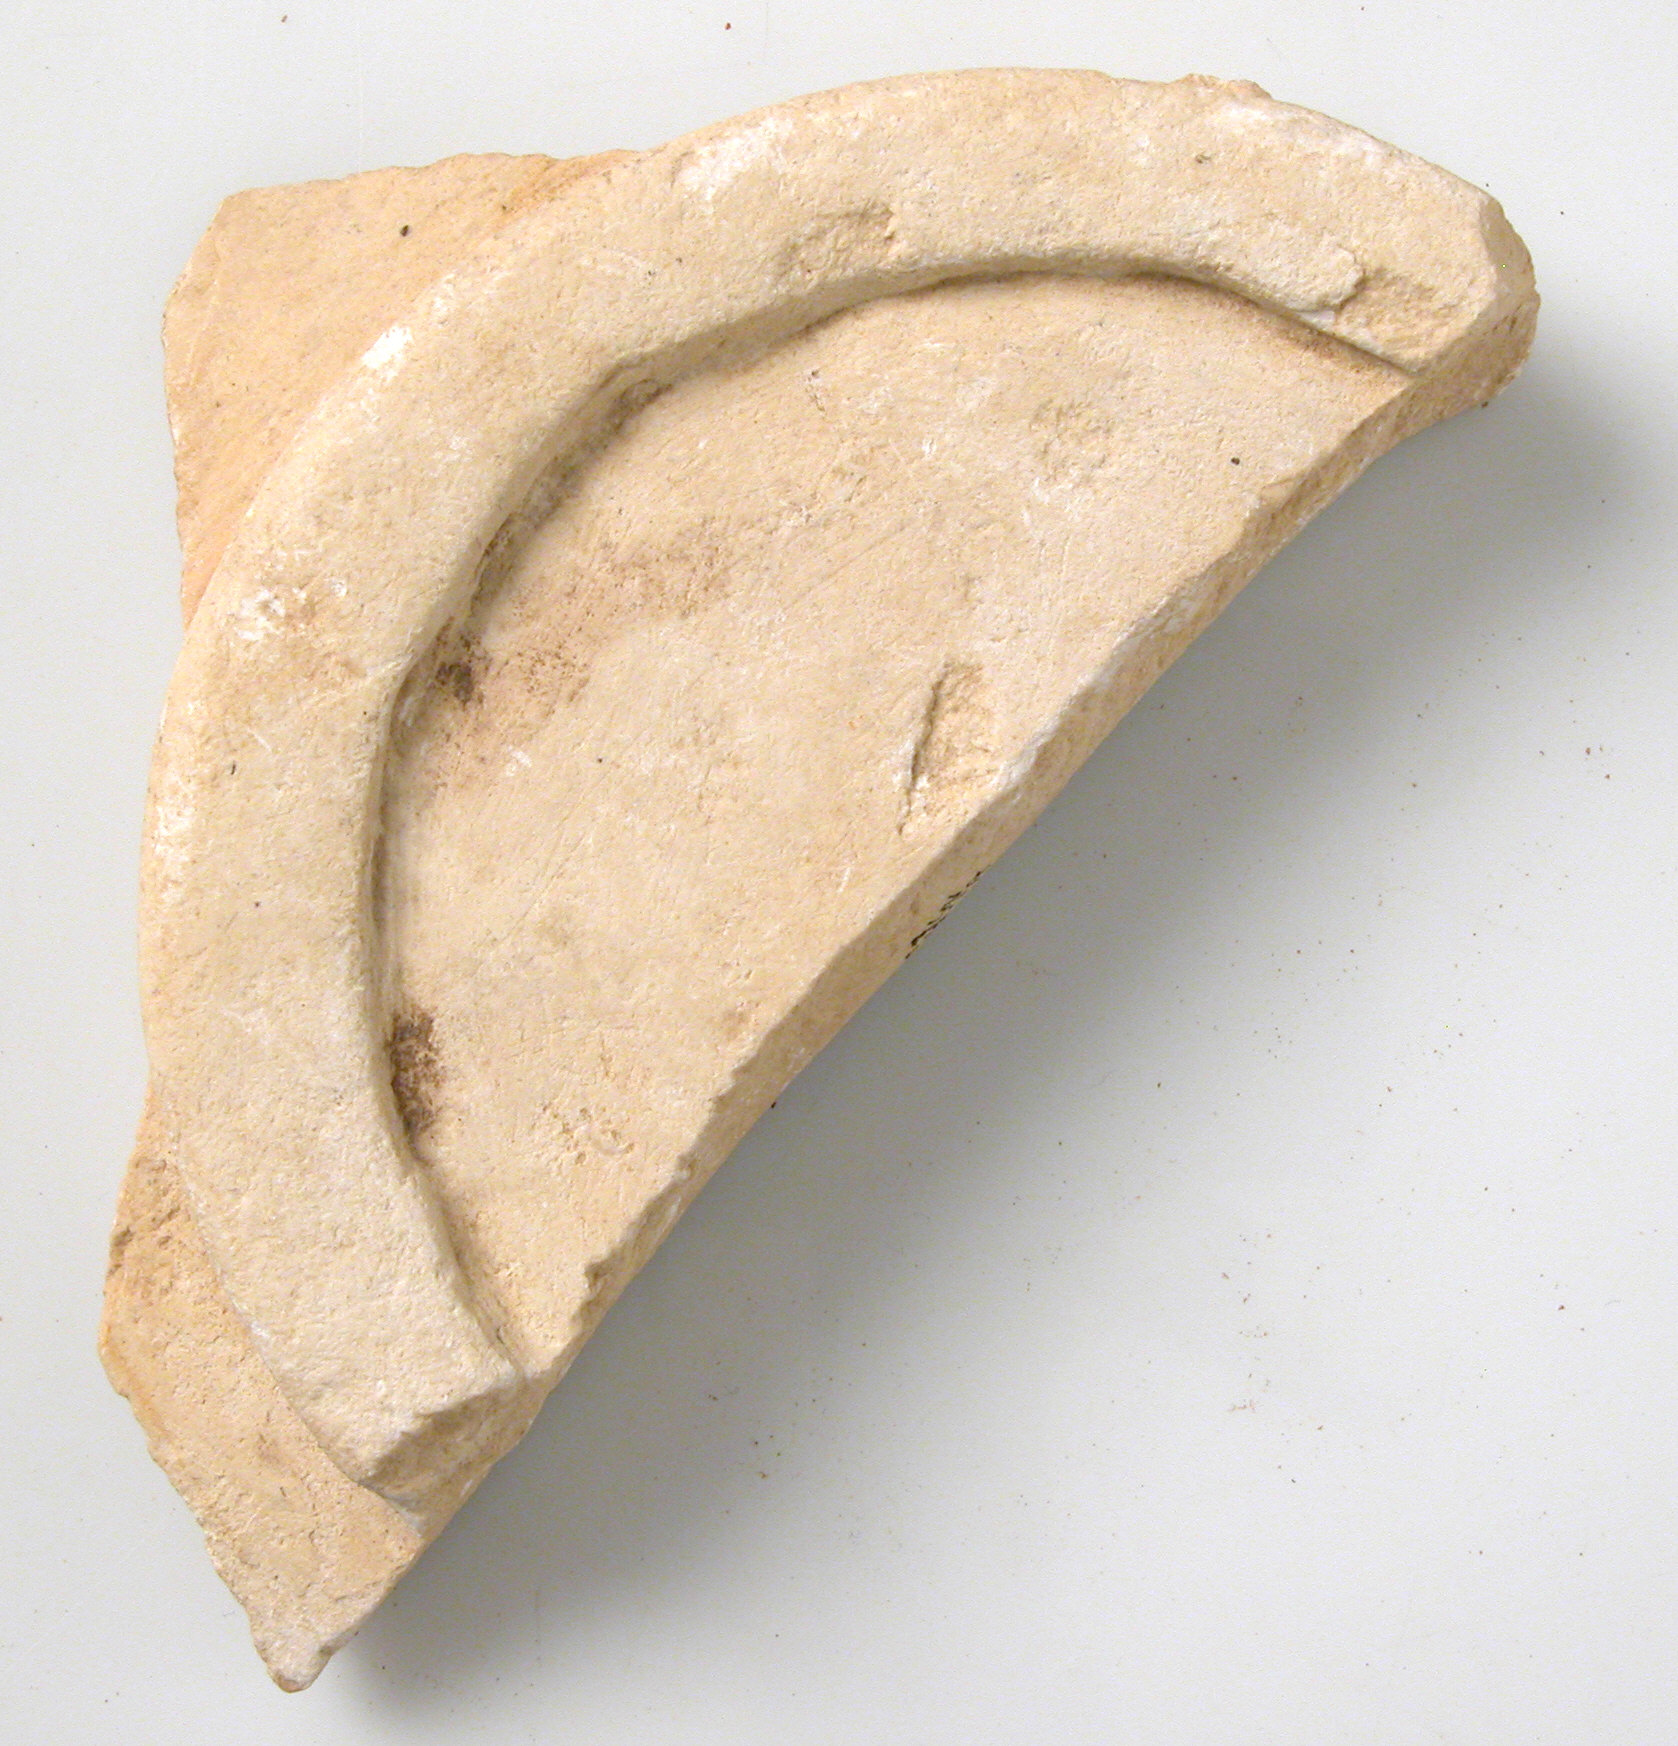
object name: fragment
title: Vessel Fragment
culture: coptic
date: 301-700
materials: limestone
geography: egypt